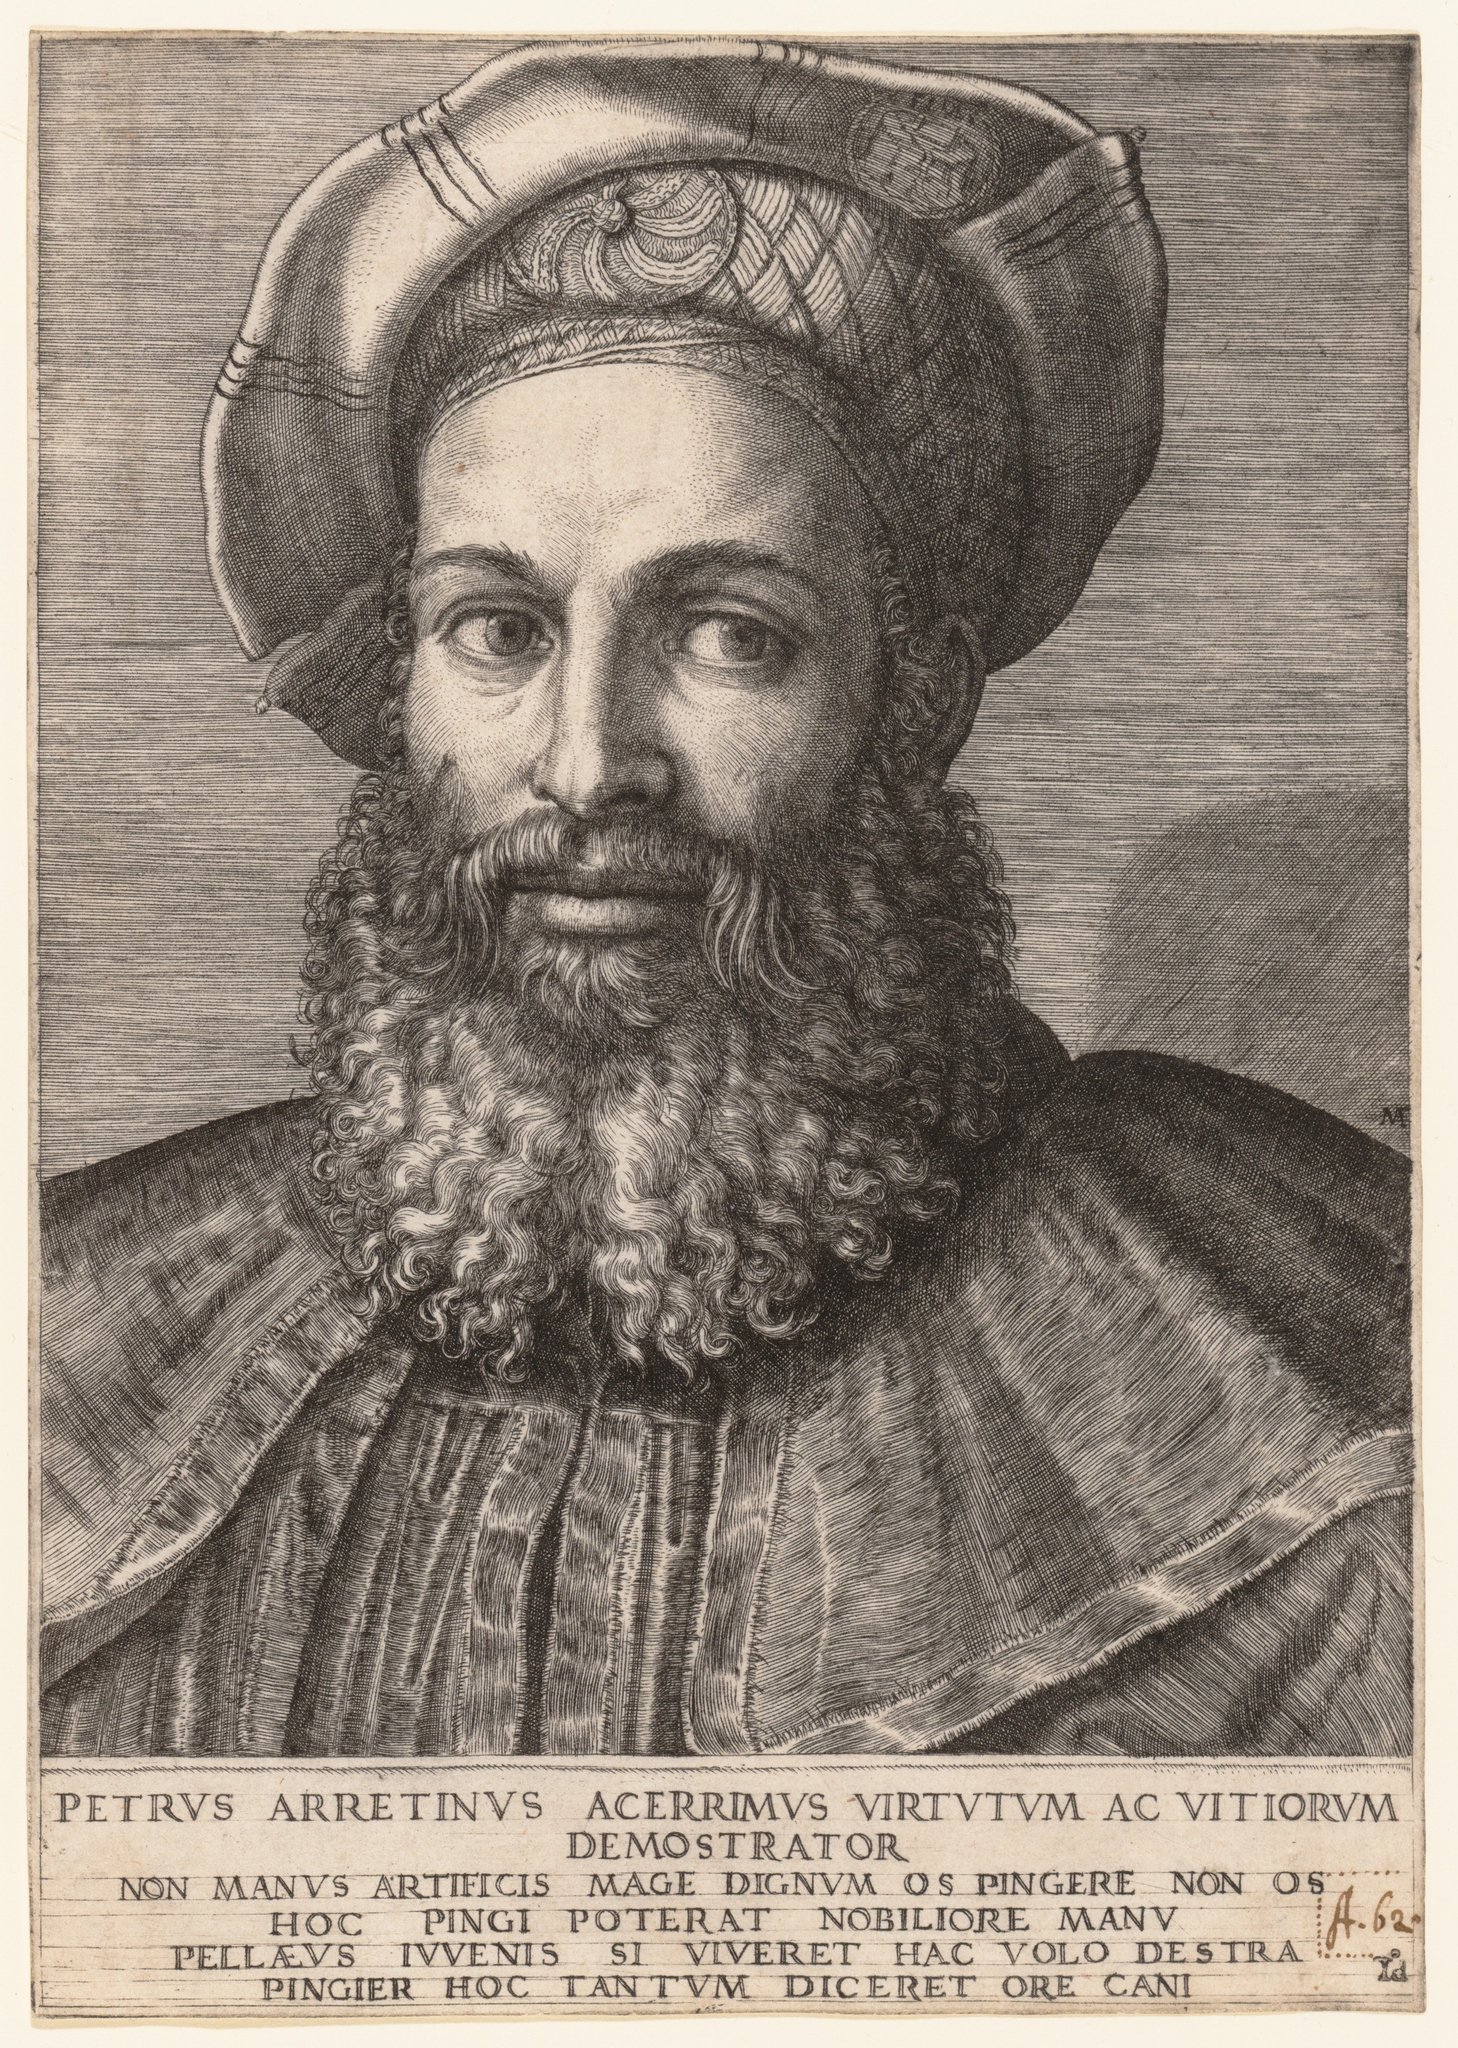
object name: print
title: Portrait of Pietro Aretino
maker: marcantonio raimondi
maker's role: artist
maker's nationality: italian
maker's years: 1475-1534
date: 1517-1520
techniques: engraving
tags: men,portraits,authors